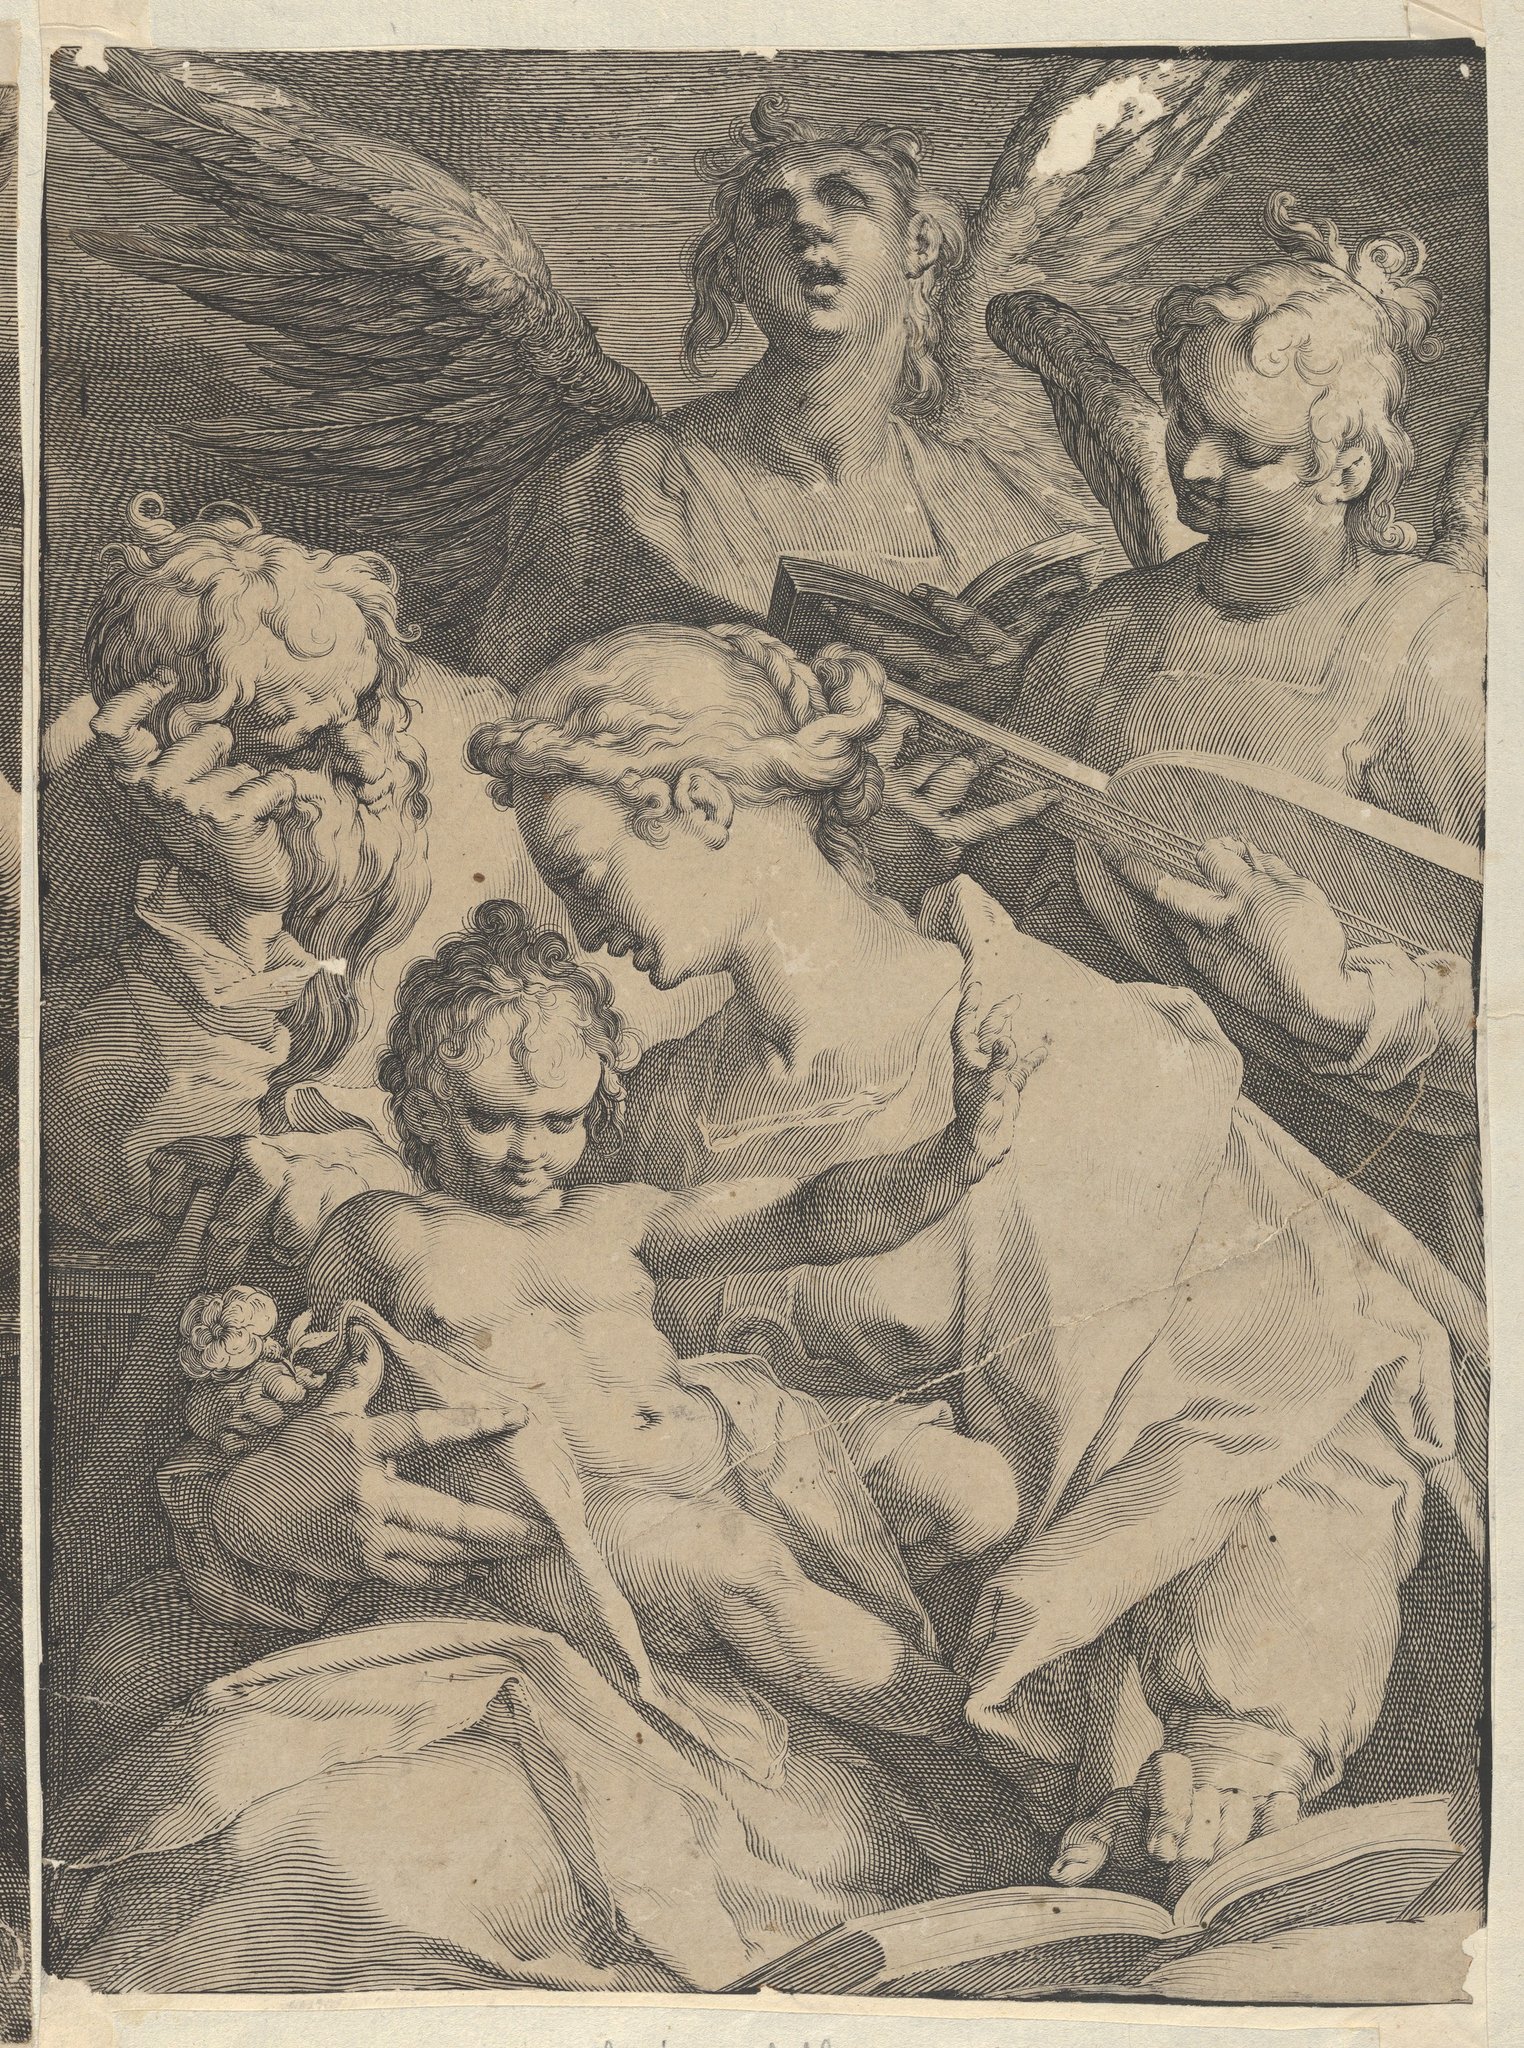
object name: print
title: Holy Family and Two Music-Making Angels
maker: jan muller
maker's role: artist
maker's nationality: netherlandish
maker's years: 1571-1628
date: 1588-1592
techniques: engraving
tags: musical instruments,angels,christ,holy family,saint joseph,virgin mary,musicians